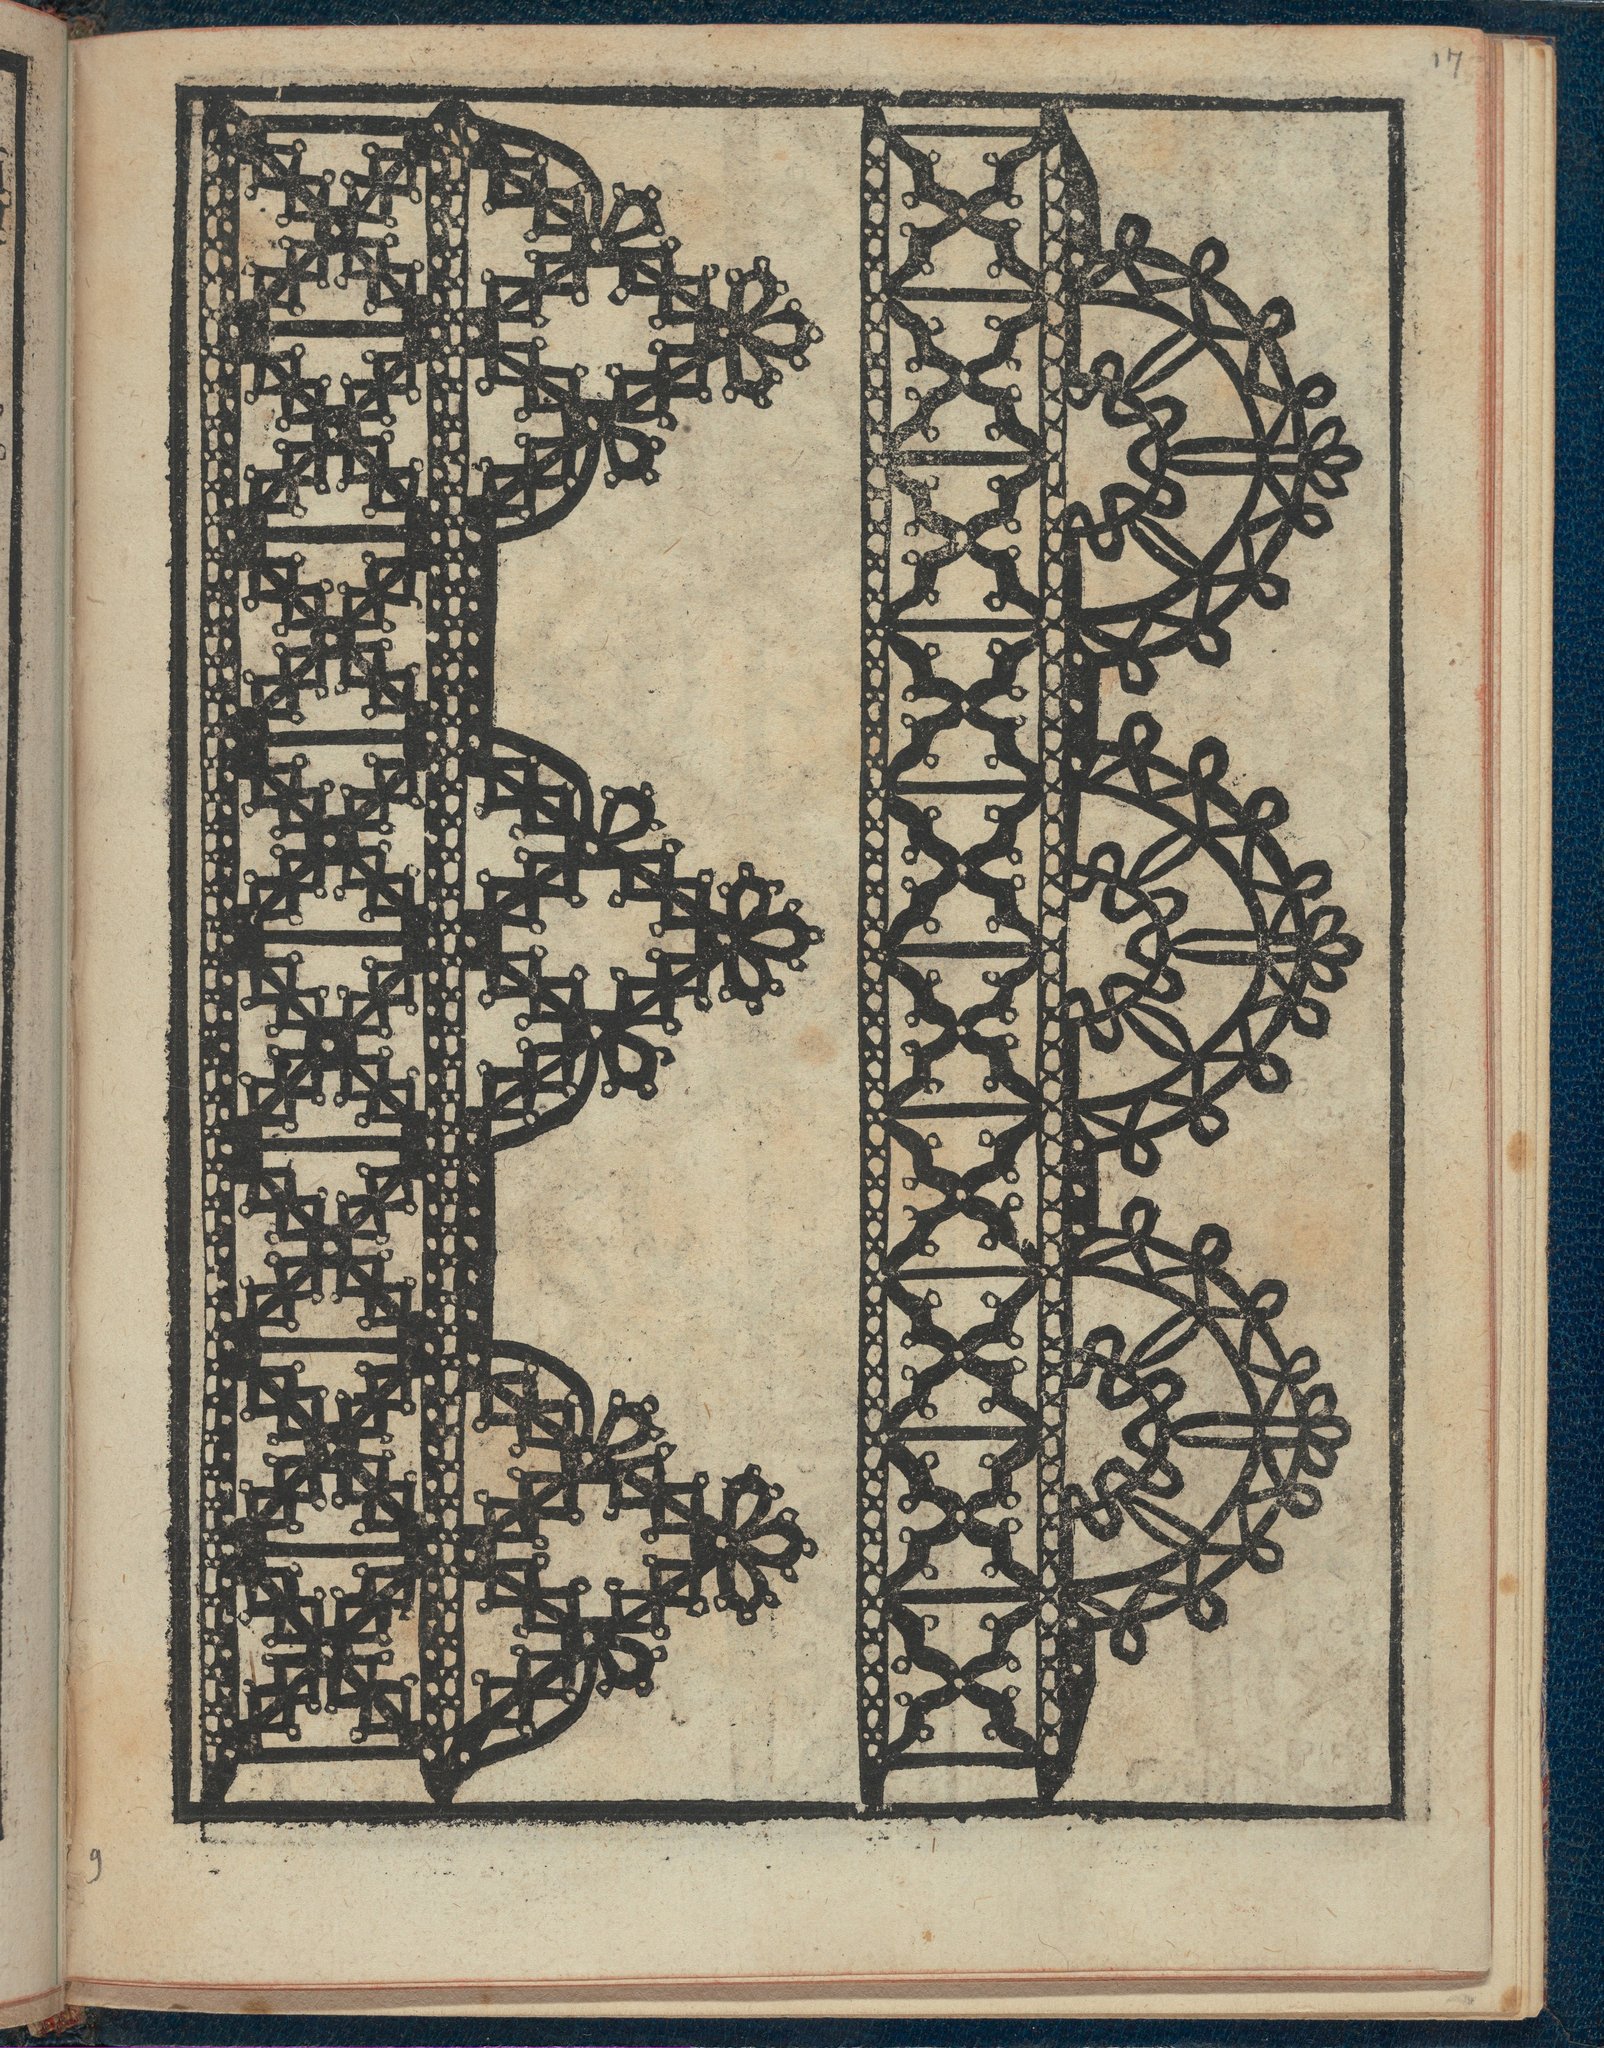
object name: book print ornament architecture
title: Le Pompe: Opera Nova, page 9 (recto)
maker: giovanni battista & marchio sessa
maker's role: publisher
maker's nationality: italian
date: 1557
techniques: woodcut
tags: ornament